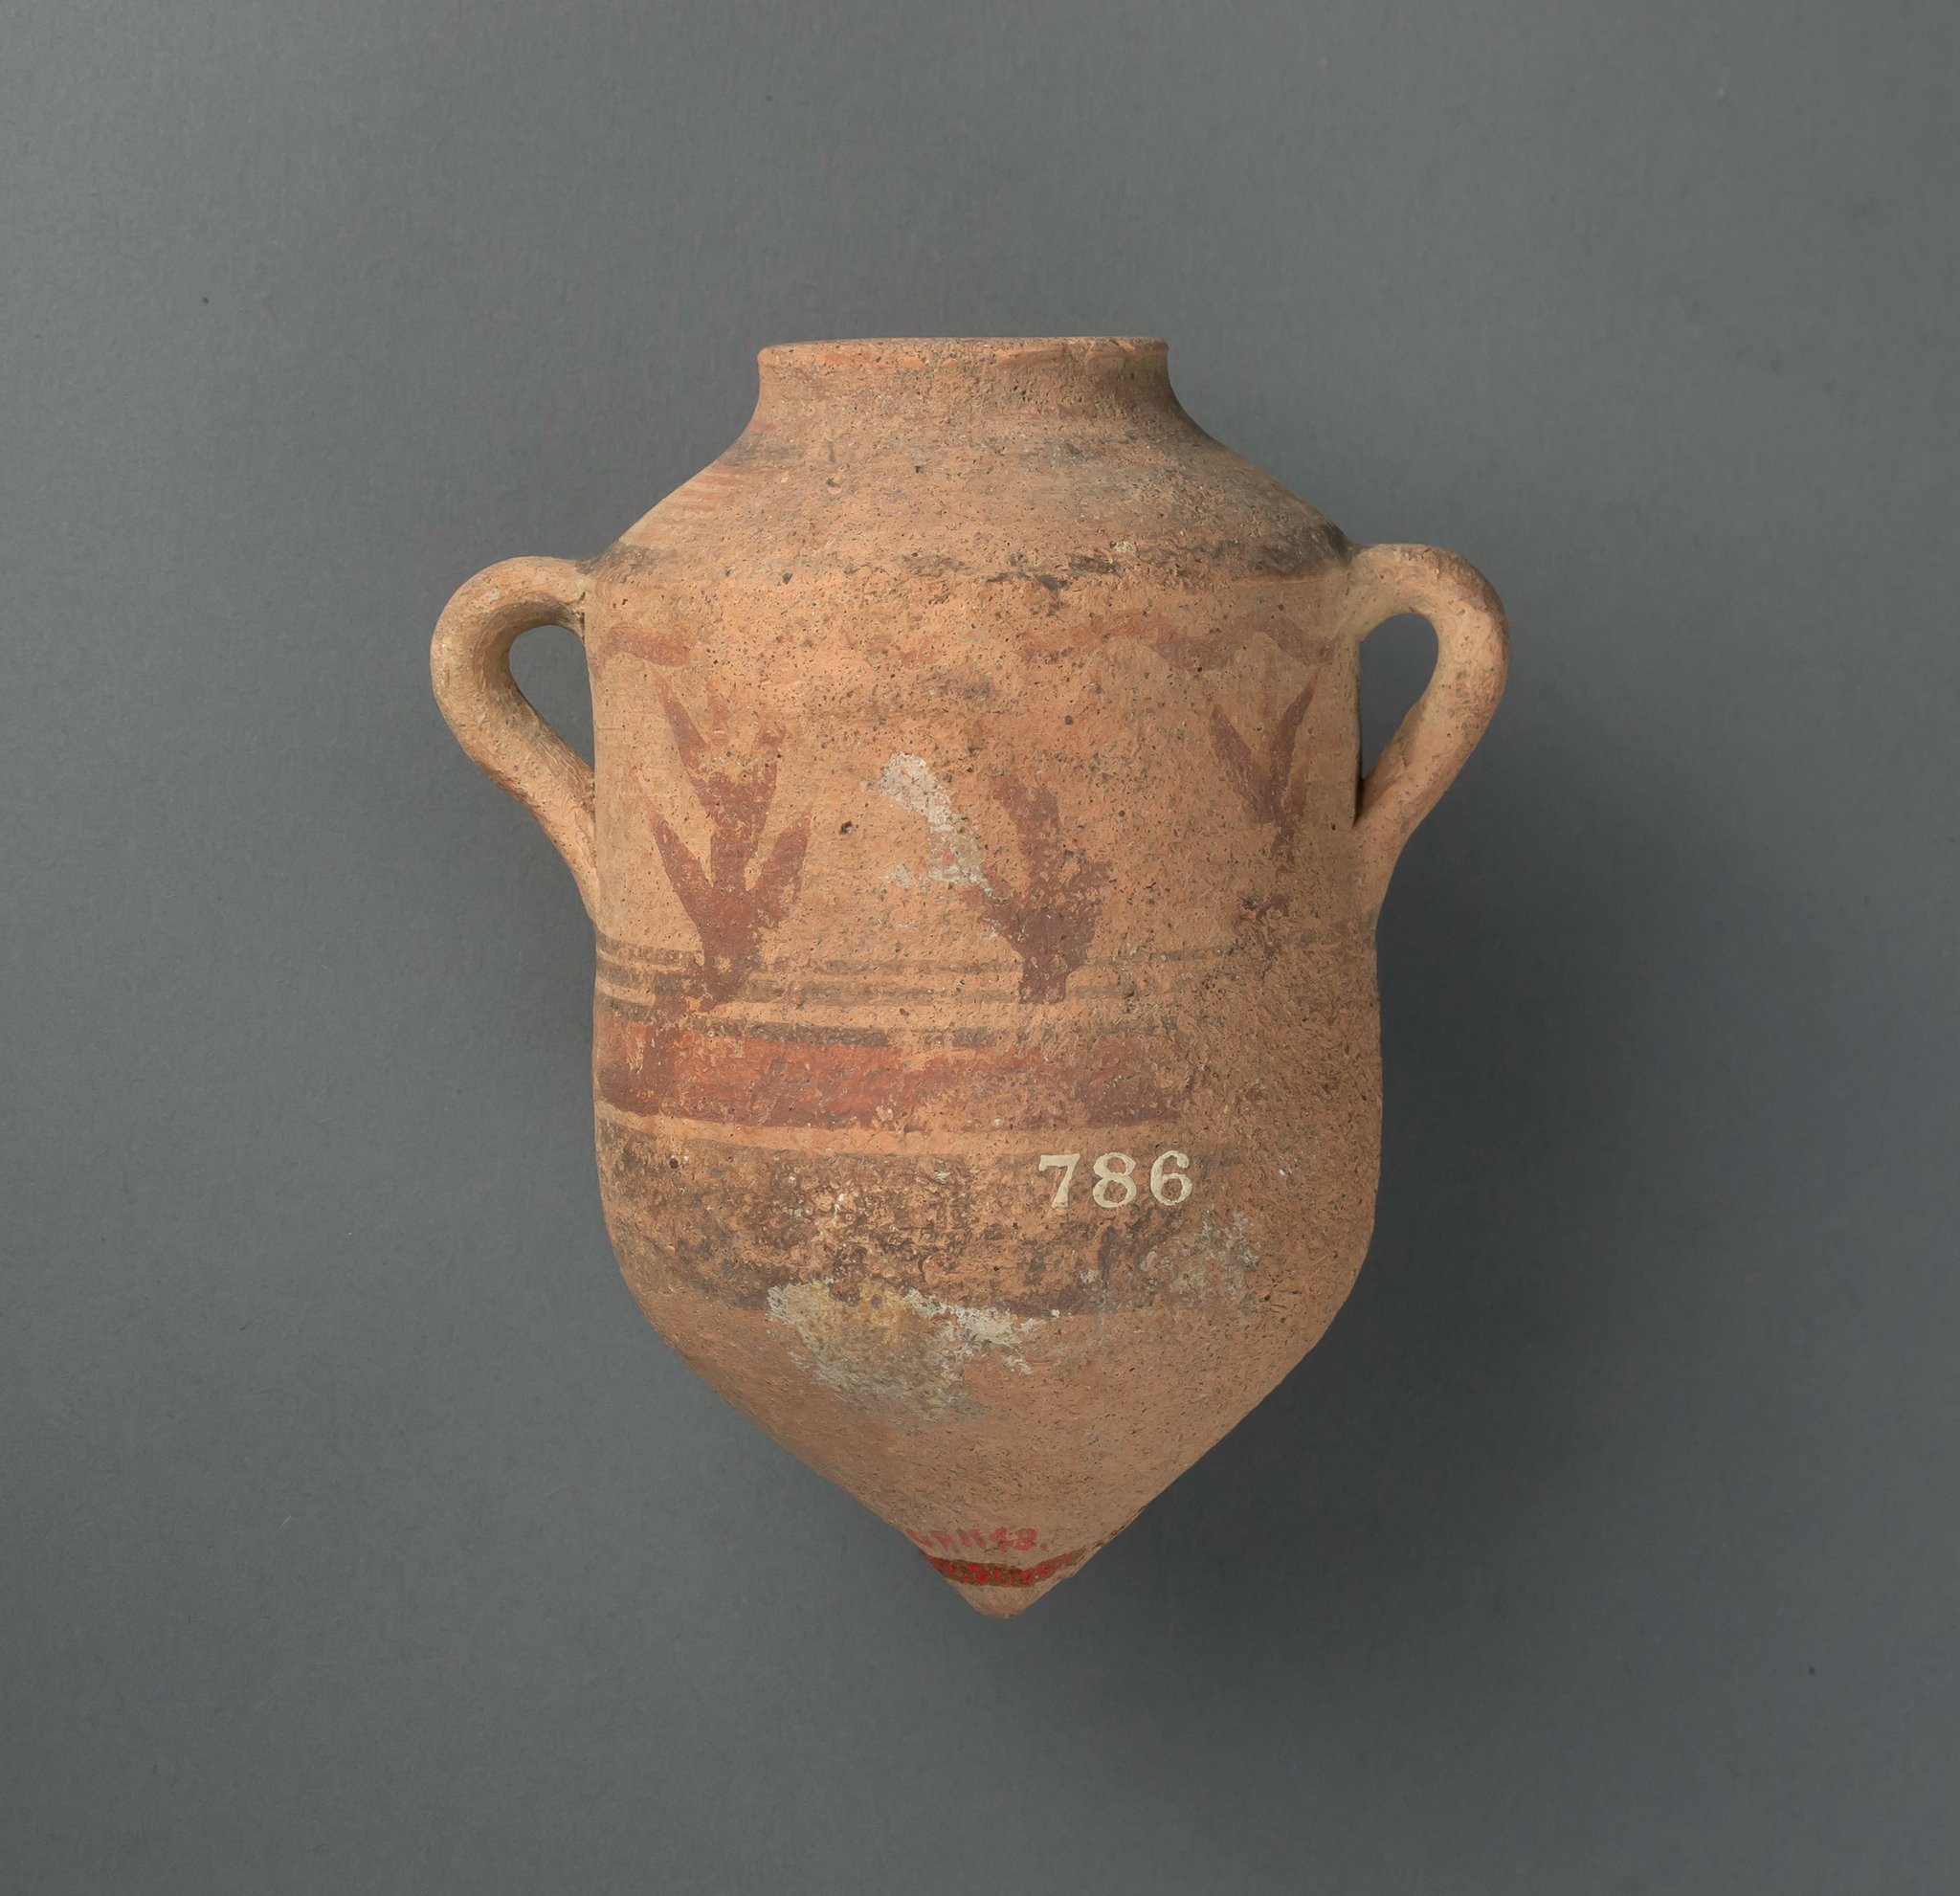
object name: jar, canaanite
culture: cypriot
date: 600-480 BCE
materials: terracotta